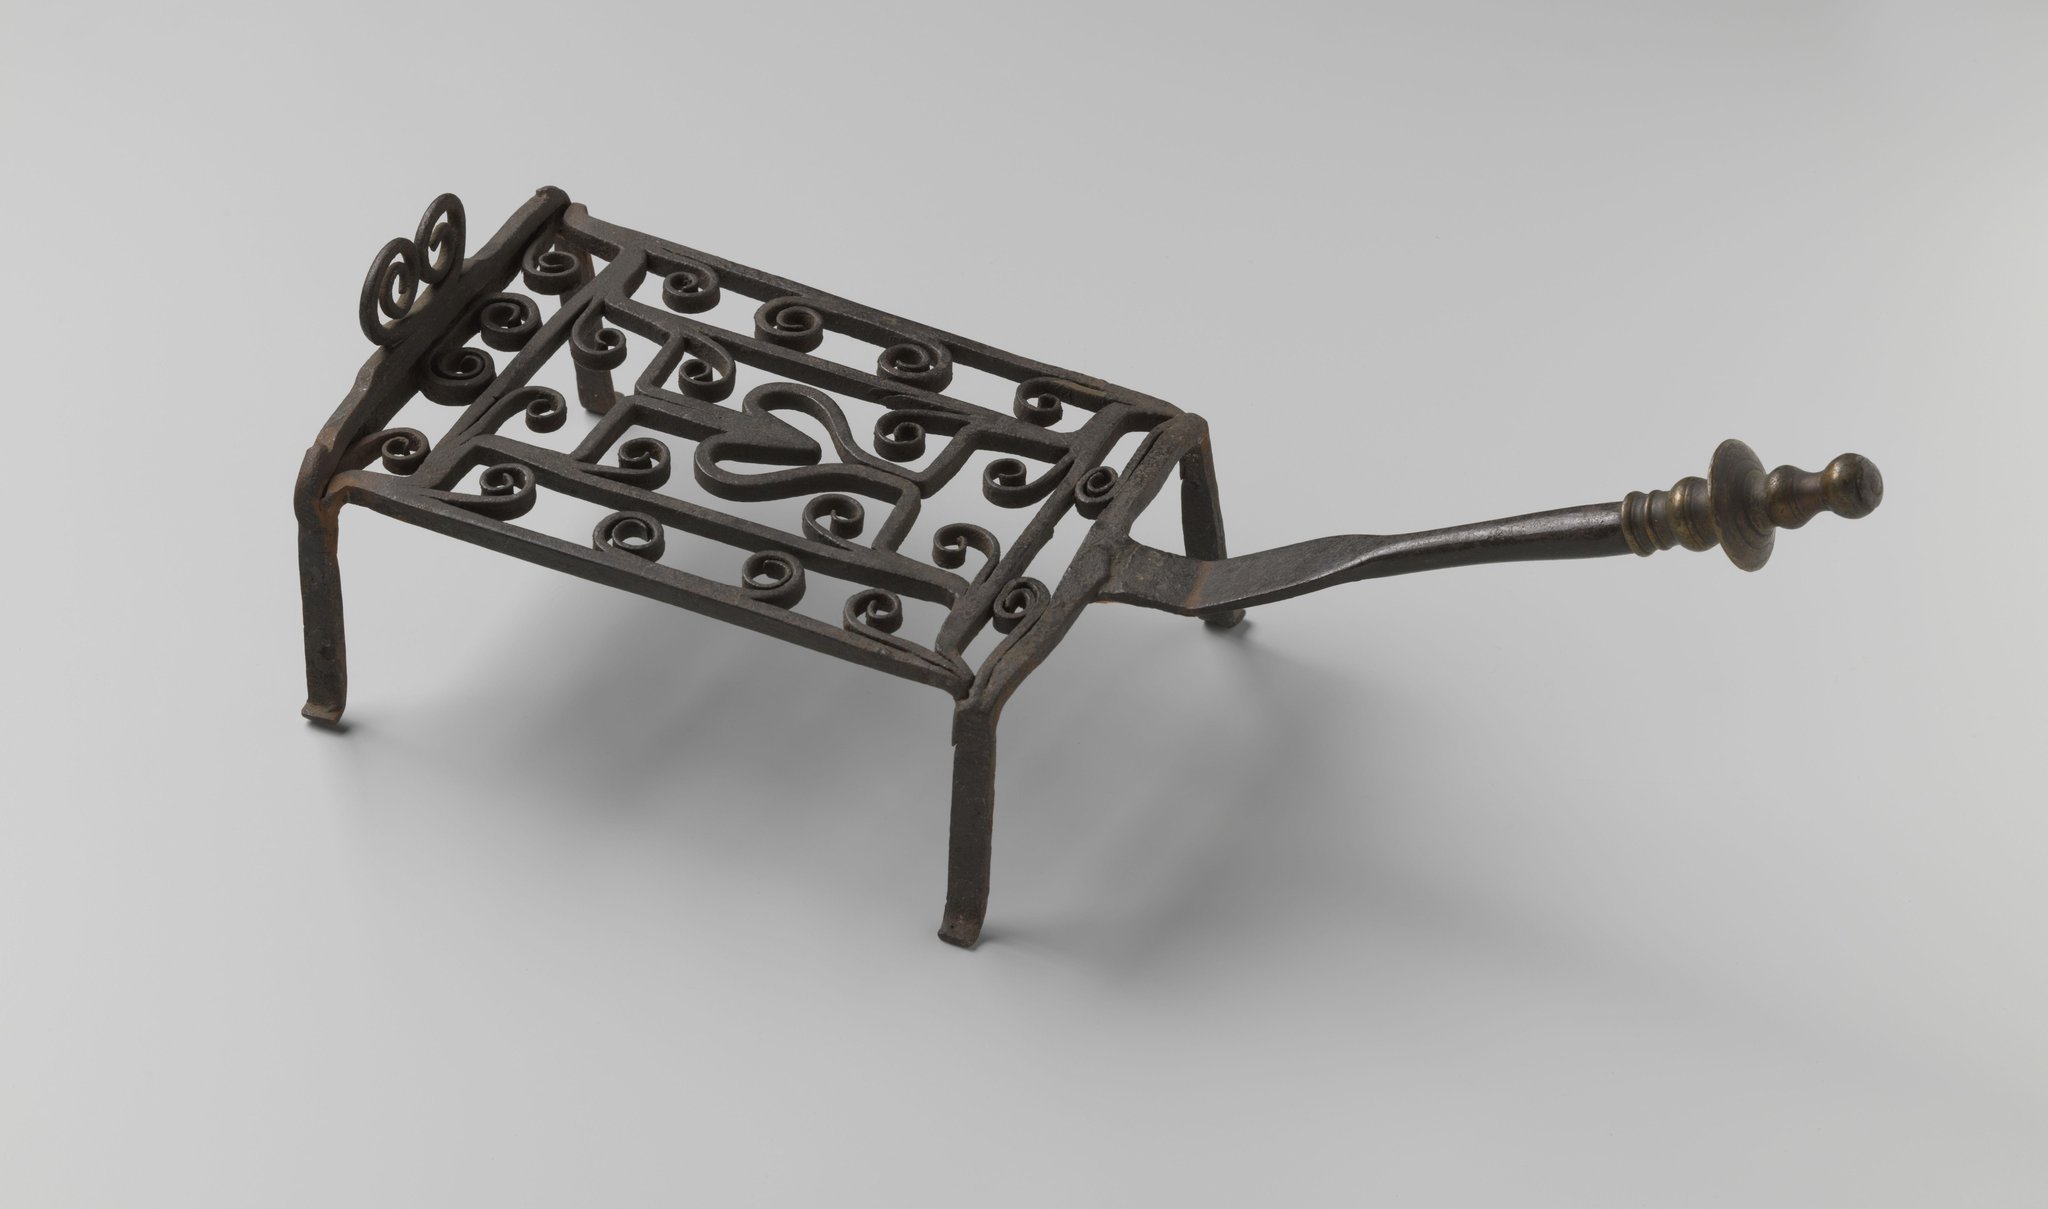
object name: rooster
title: Rooster van ijzer met een koperen knop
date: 1400-1950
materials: copper, iron